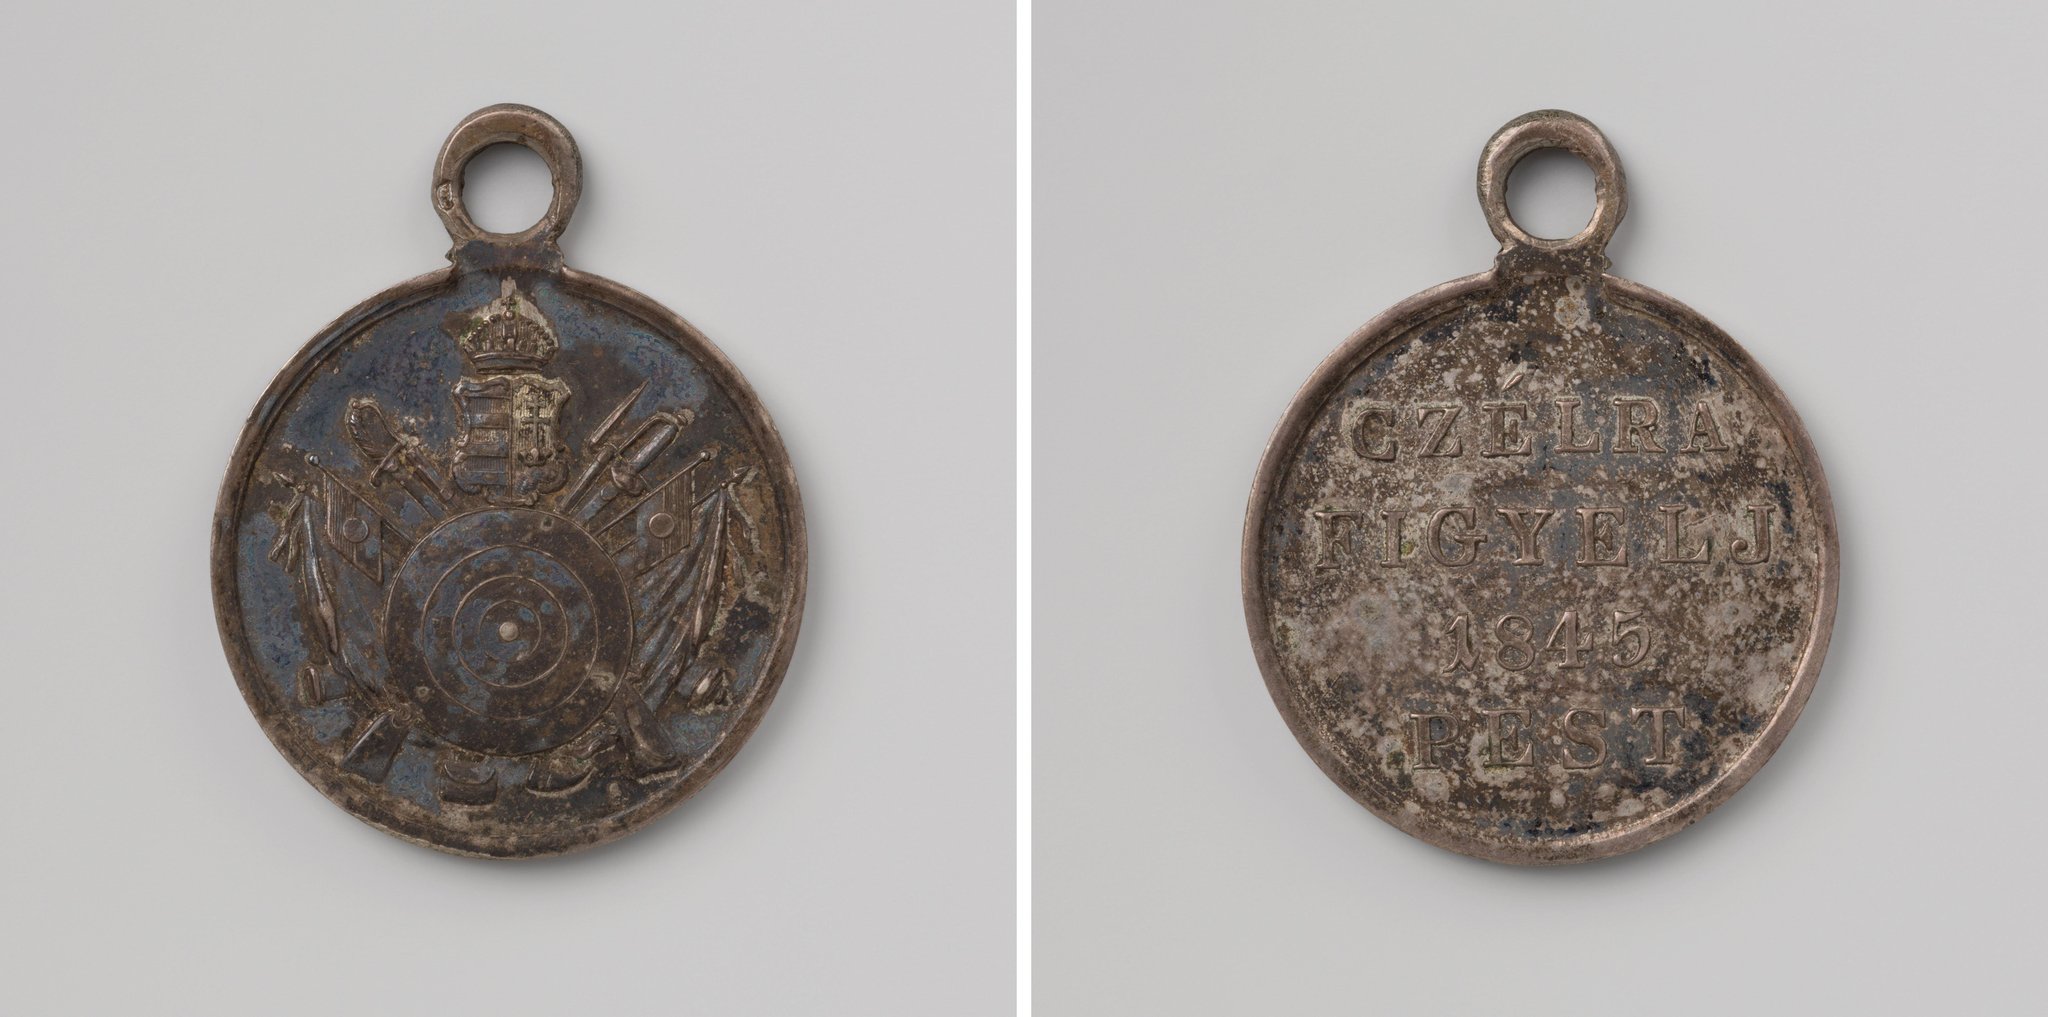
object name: marksman medal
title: Schutterij van Pest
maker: Anonymous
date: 1845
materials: silver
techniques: striking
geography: hungary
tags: pest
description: Zilveren penning aan draagoog. Voorzijde: opschrift. Keerzijde: gekroond wapenschild boven schietschijf; daarachter vaandels, zwaarden en ander wapentuig